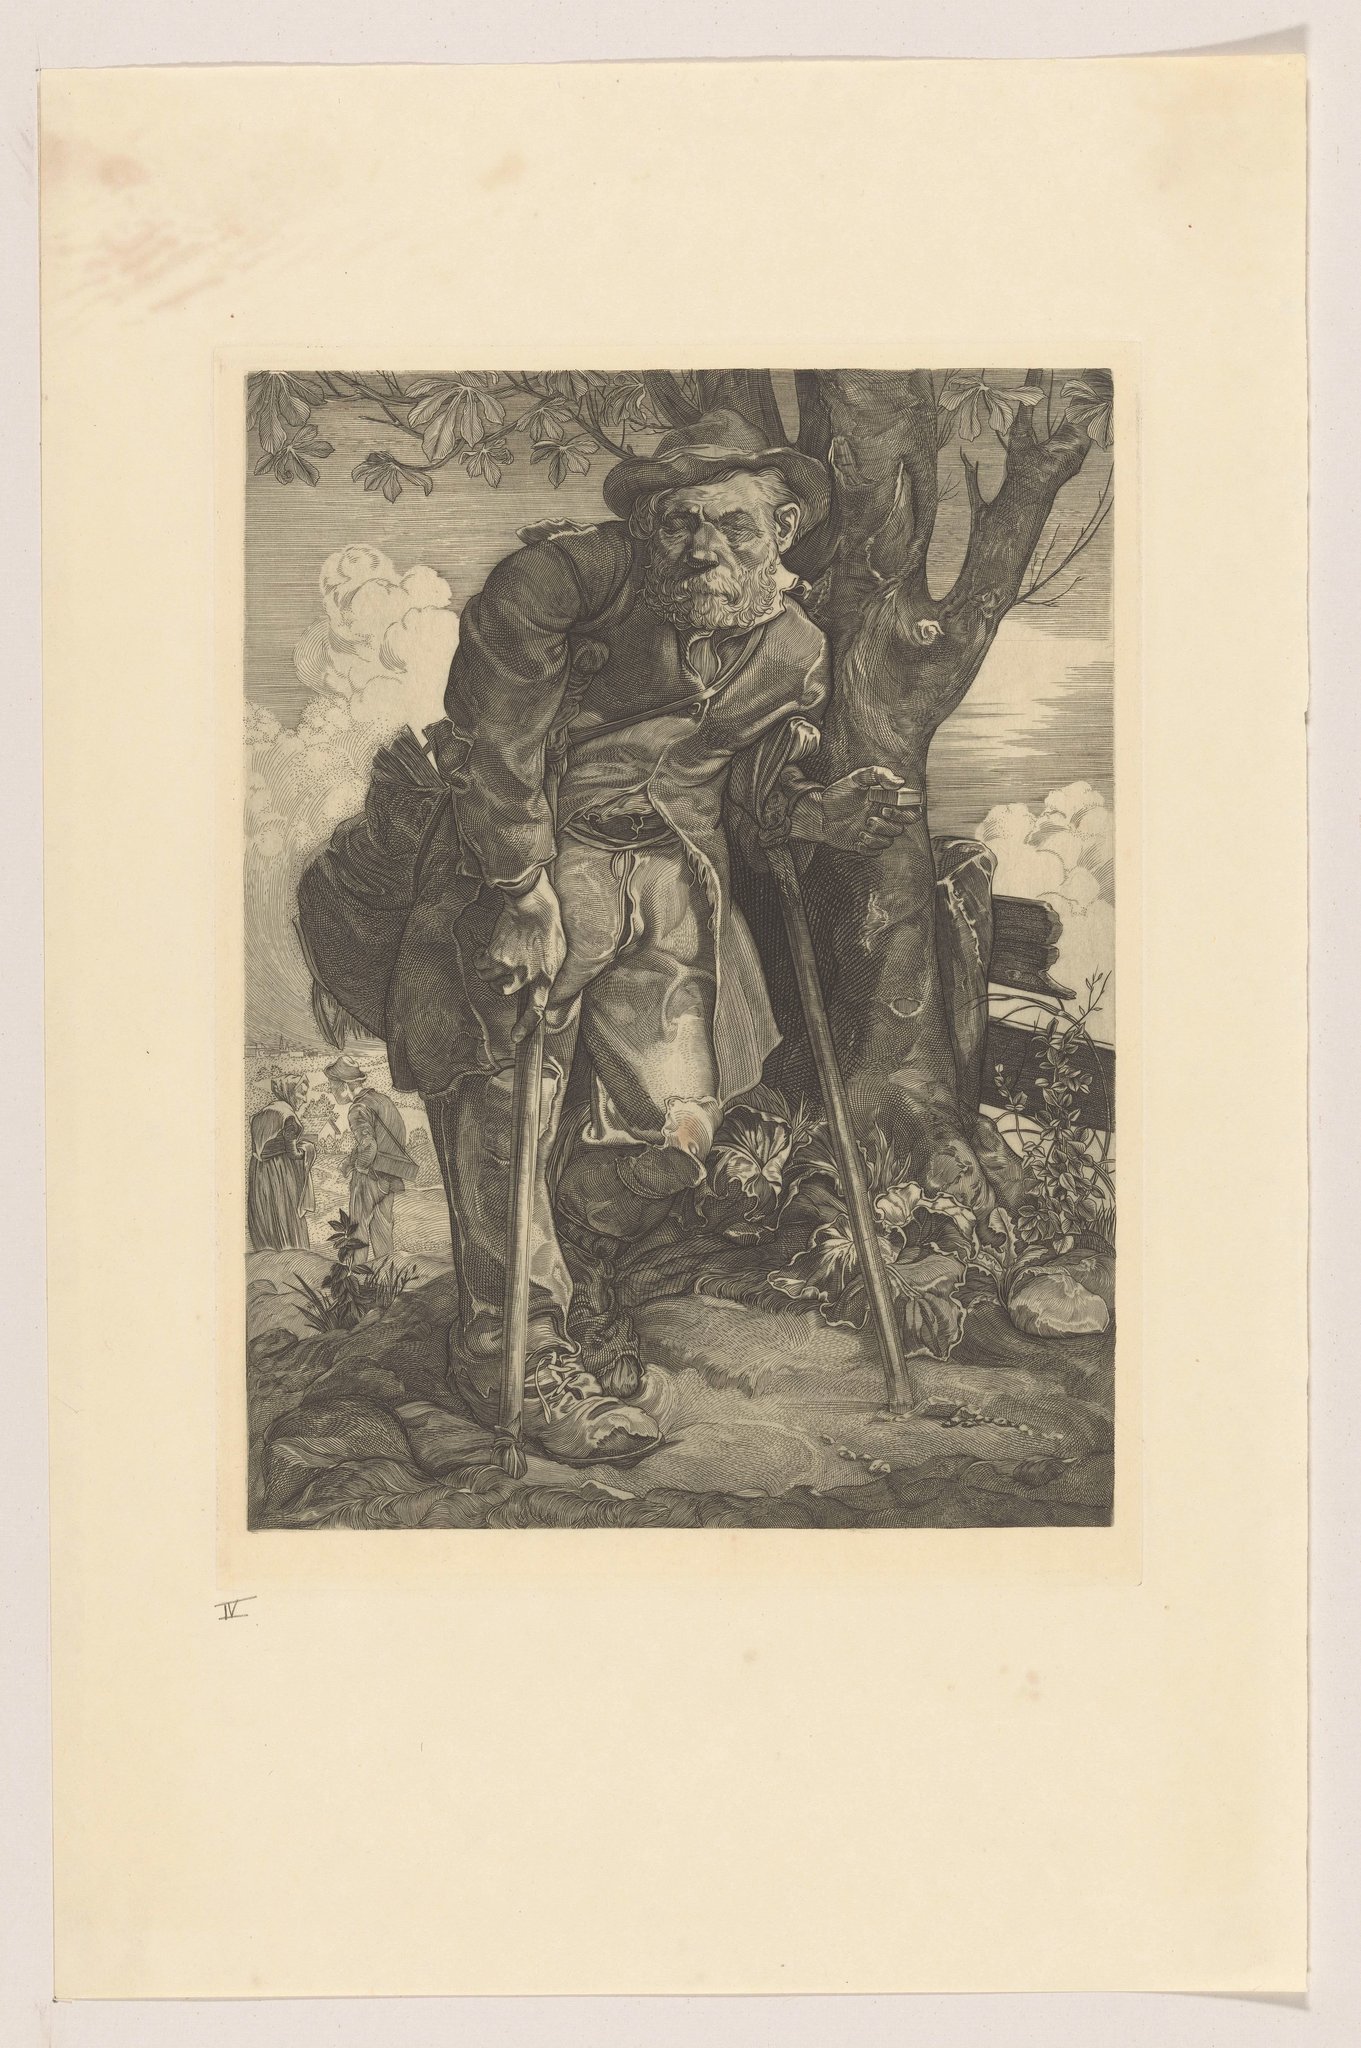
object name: print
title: Bedelaar met krukken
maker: johannes josephus aarts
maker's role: draughtsman, print maker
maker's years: 1871-1934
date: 1907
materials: paper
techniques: engraving, intaglio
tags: crutches, beggar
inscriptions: collector's mark: Lugt 2166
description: Een bebaarde man met hoed, gekleed in beschadigde, deels herstelde kleren, lopend met twee krukken. In zijn linkerhand een klein, rechthoekig voorwerp. Linksachter hem een man en een vrouw, rechtsachter hem een boom.